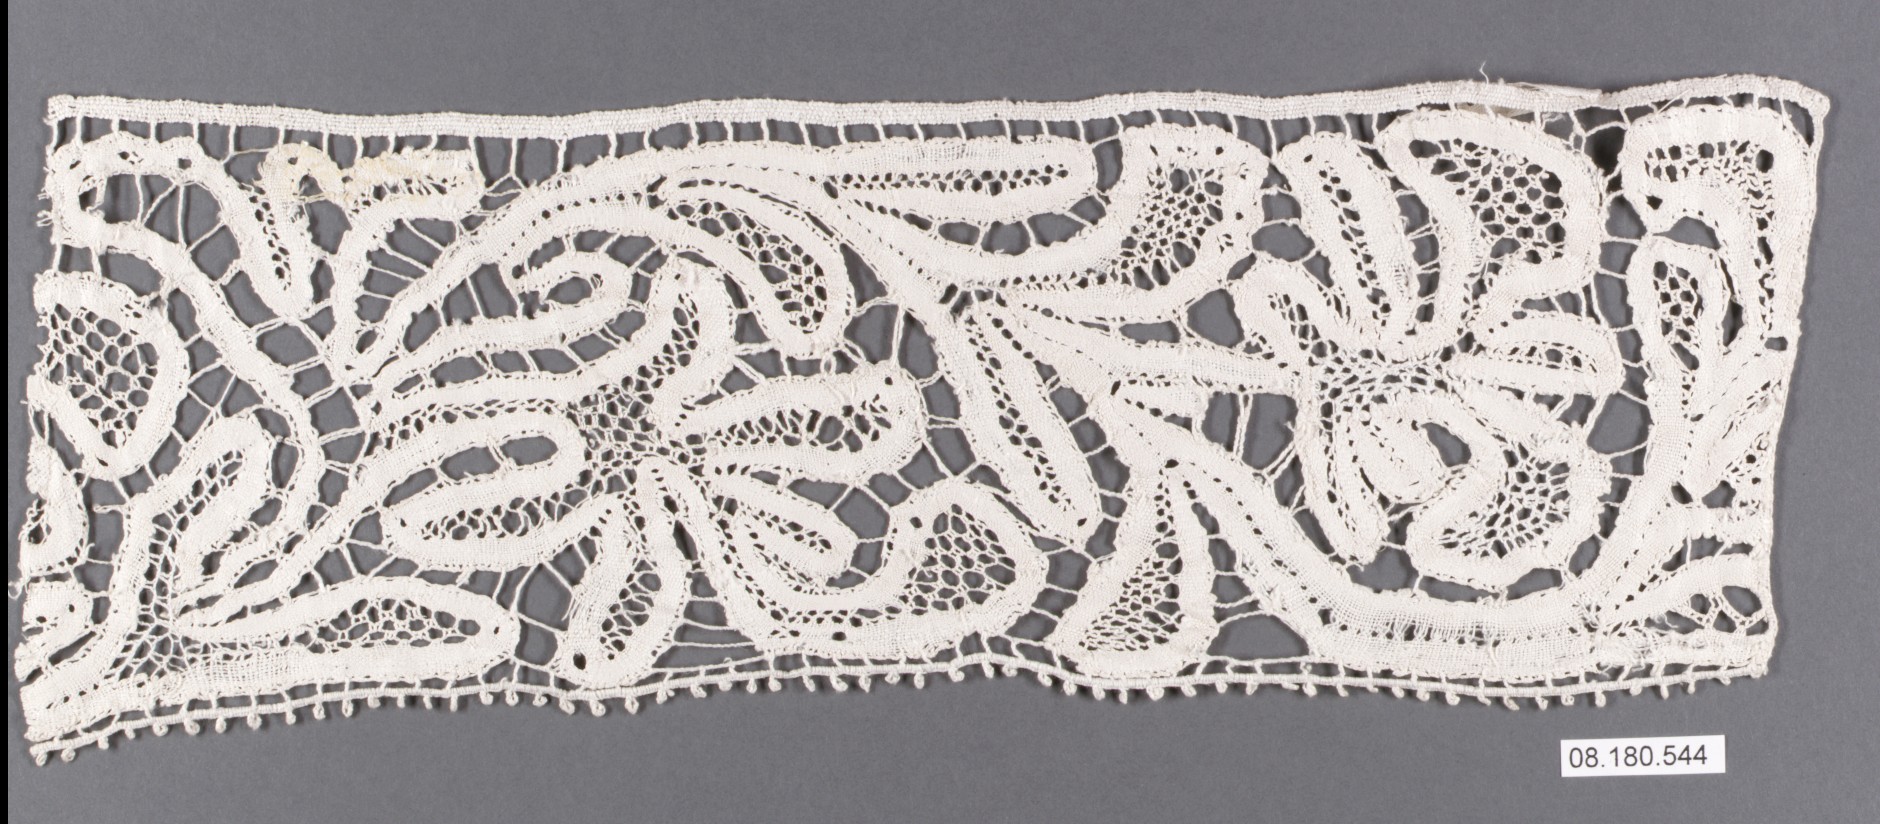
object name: fragment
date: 1601-1700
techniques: lace